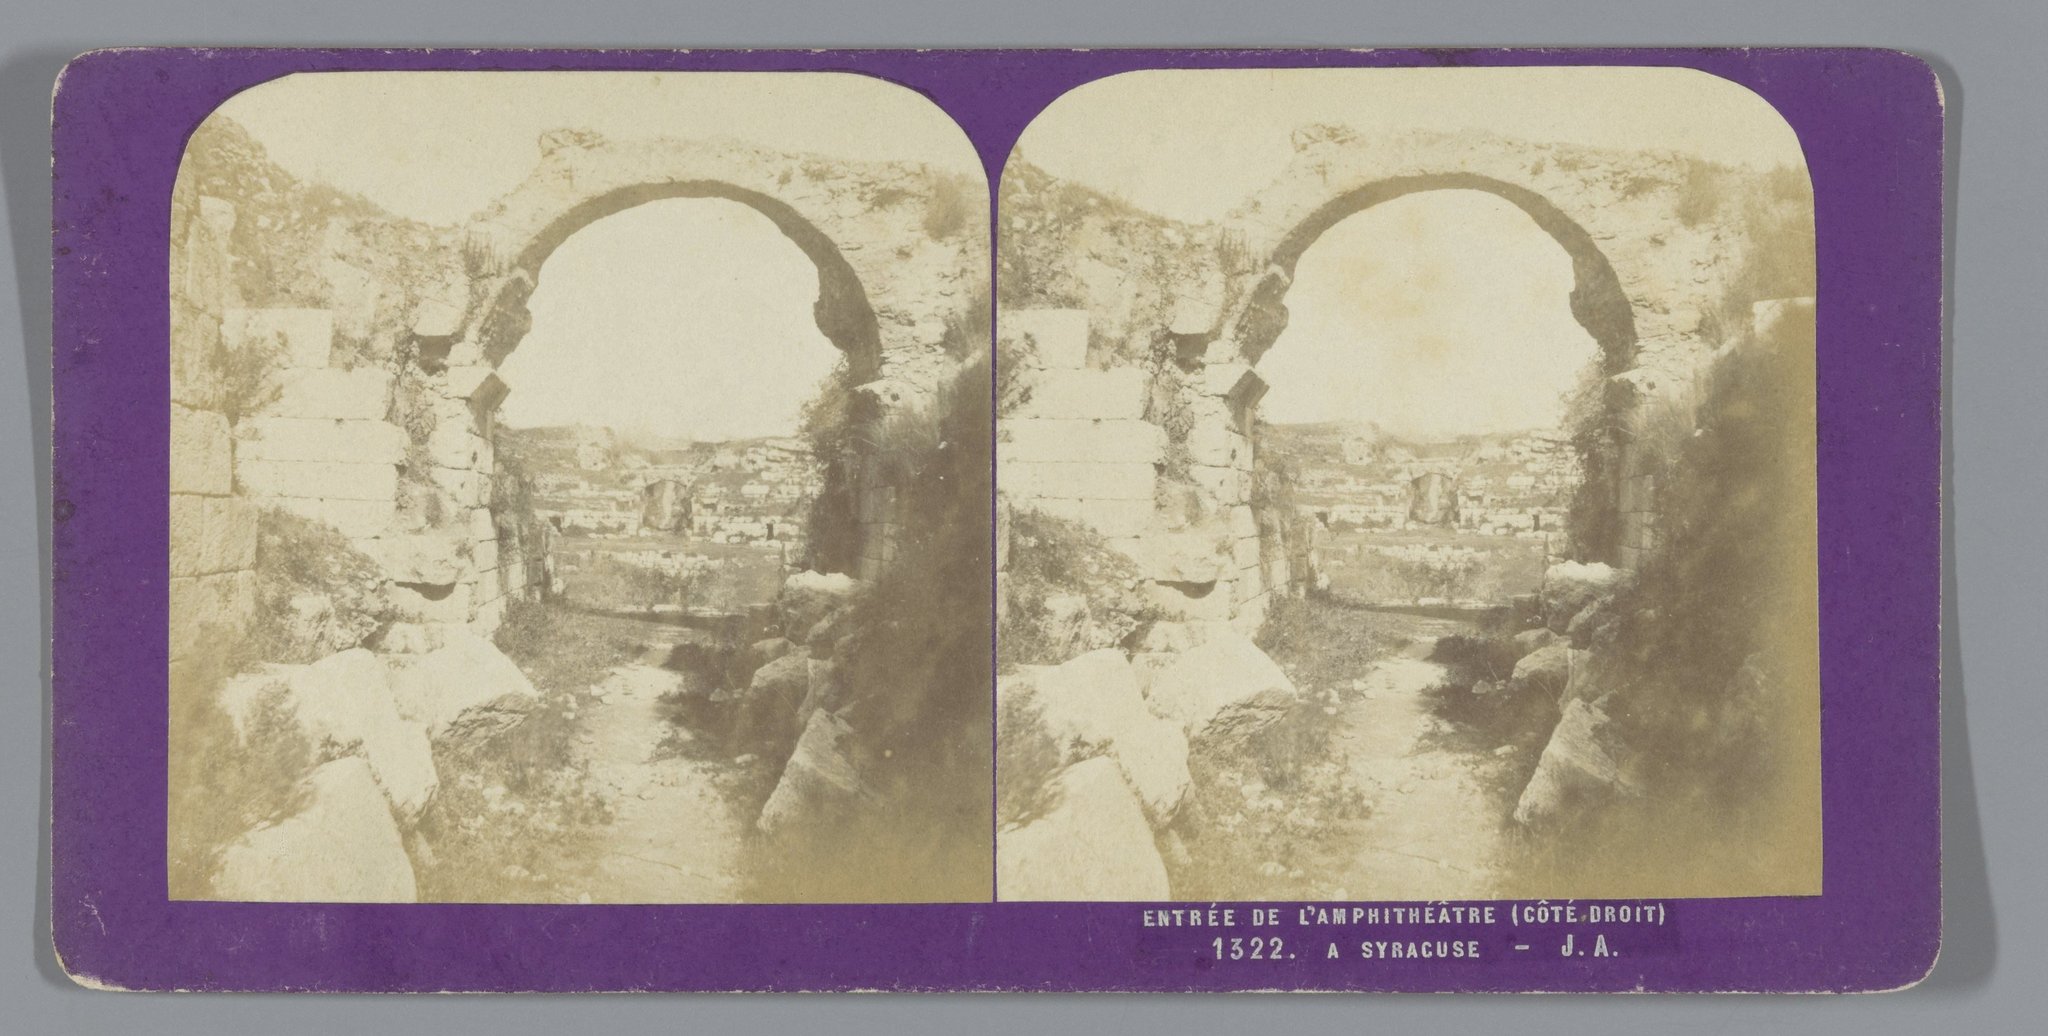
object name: stereograph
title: Entrée de l'Amphithéâtre (côté droit) a Syracuse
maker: jean andrieu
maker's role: fotograaf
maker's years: 1816-1872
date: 1862-1876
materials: cardboard, paper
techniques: albumen print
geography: syracuse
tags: amphitheatre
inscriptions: number: ‘1322’